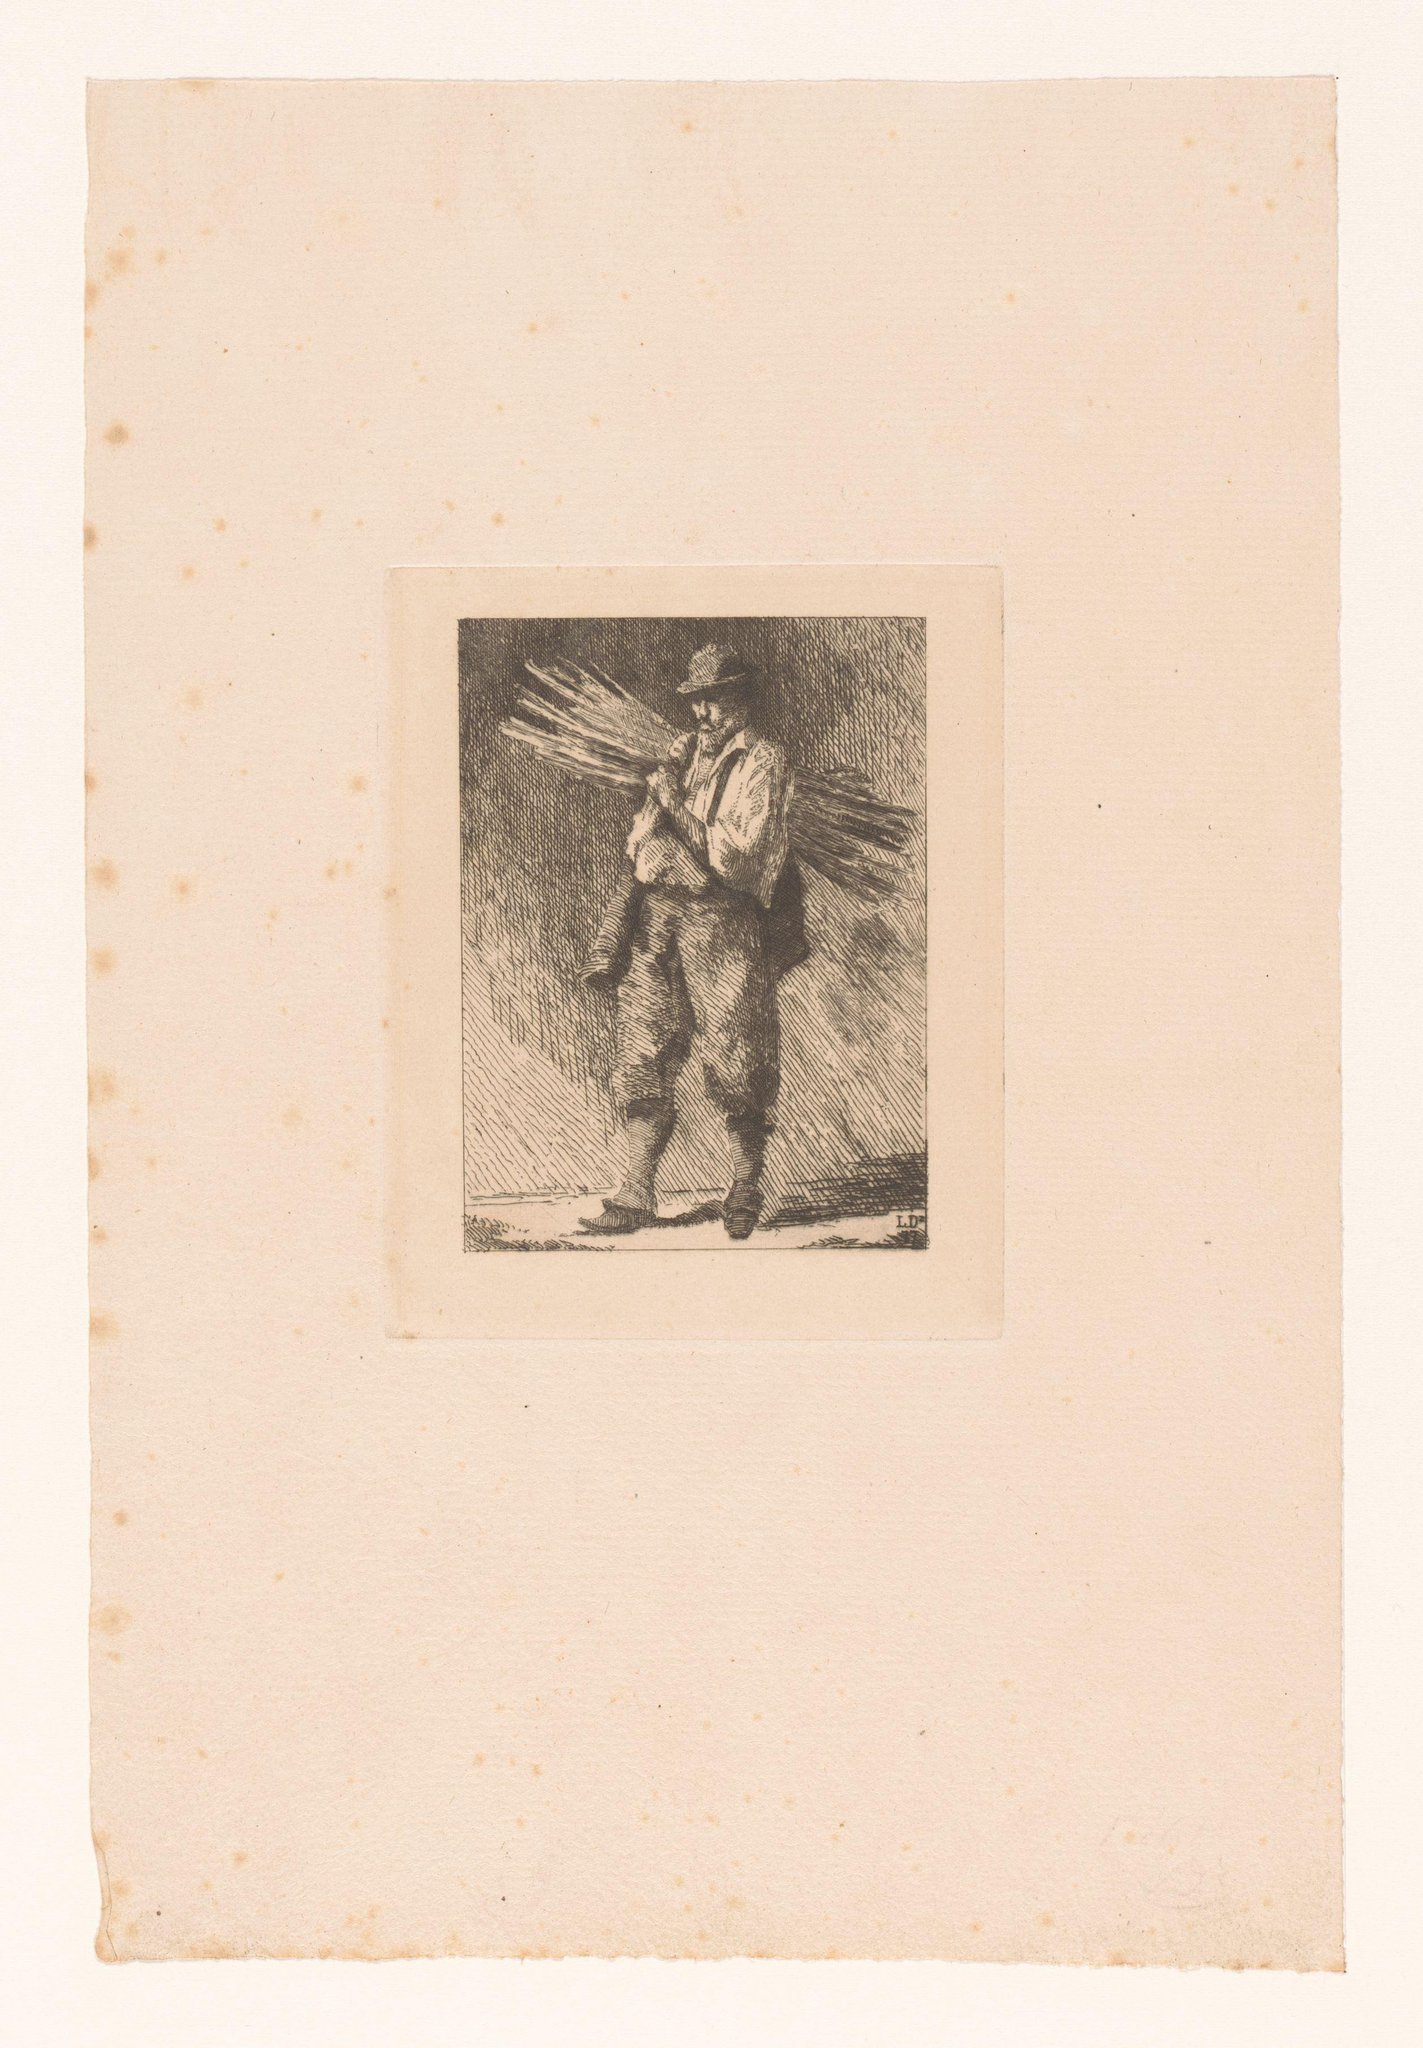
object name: print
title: Man die een bos takken over zijn schouder draagt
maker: léon dolez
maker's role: print maker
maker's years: 1837-1902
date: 1847-1902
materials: paper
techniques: etching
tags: standing figure, woodgathering, woodgatherer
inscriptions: collector's mark: Lugt 2228